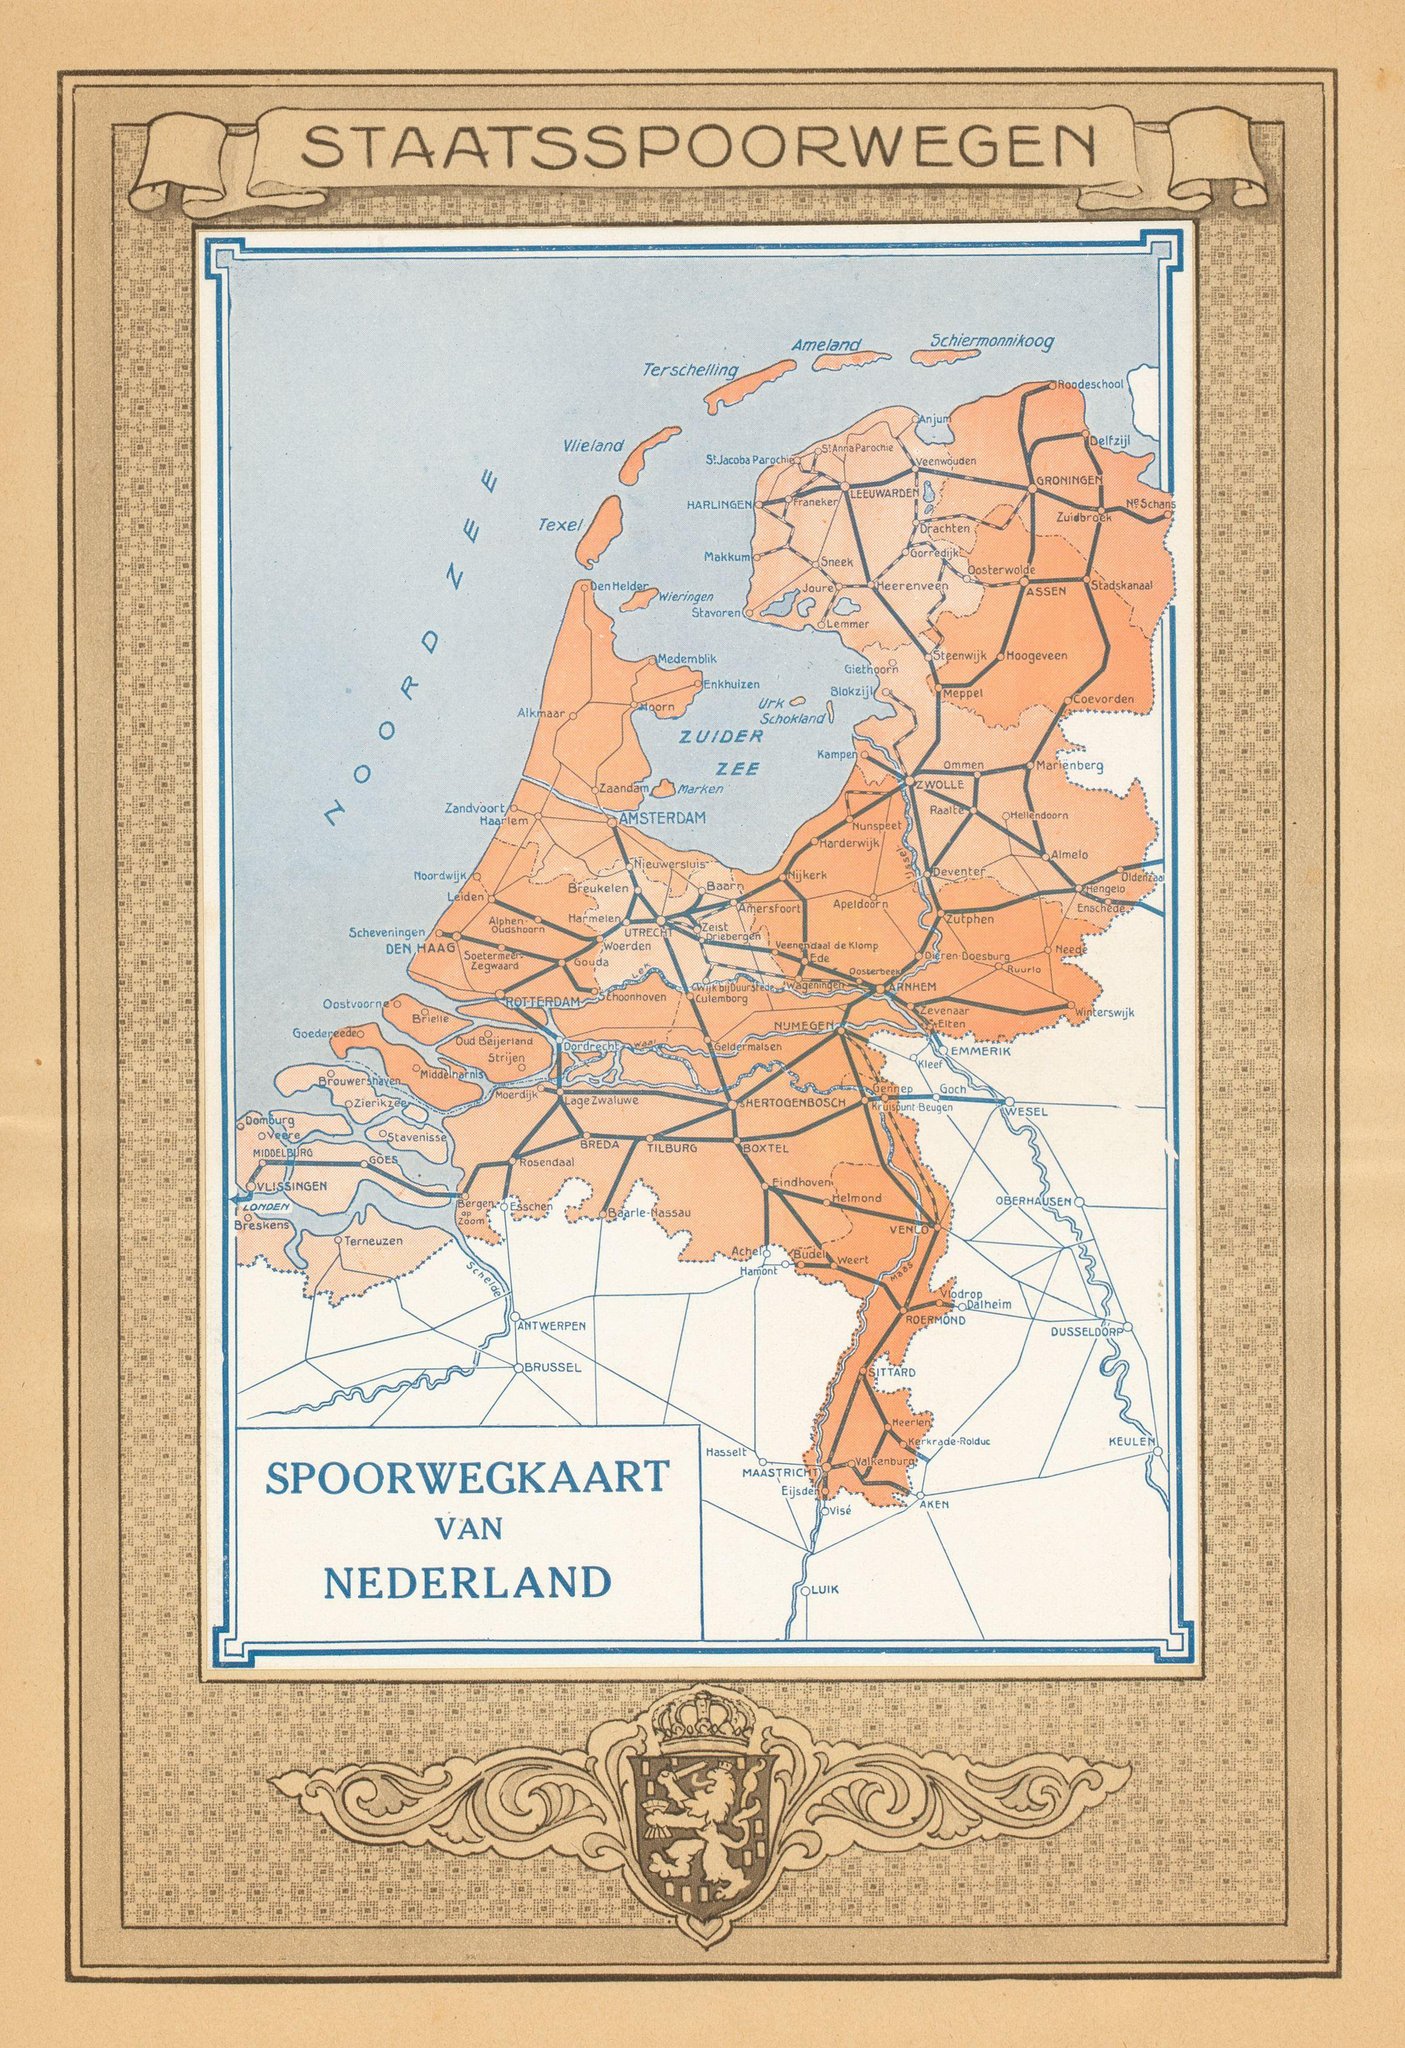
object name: album leaf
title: Spoorwegenkaart van Nederland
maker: Anonymous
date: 1915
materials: paper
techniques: printing block, rotogravure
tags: maps of separate countries or regions, railway, tramway; rack railway, netherlands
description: Deze prent maakt deel uit van een album.